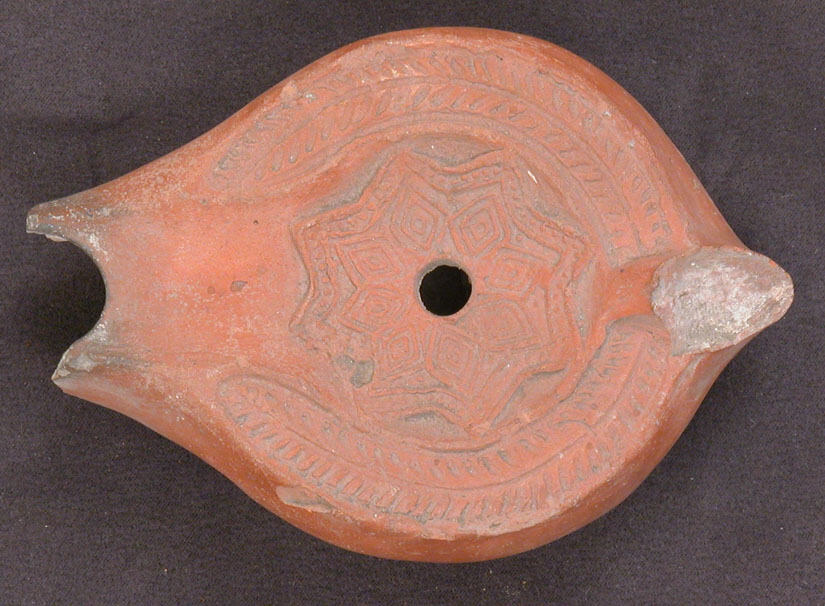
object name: lamp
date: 301-400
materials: earthenware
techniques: molding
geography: egypt